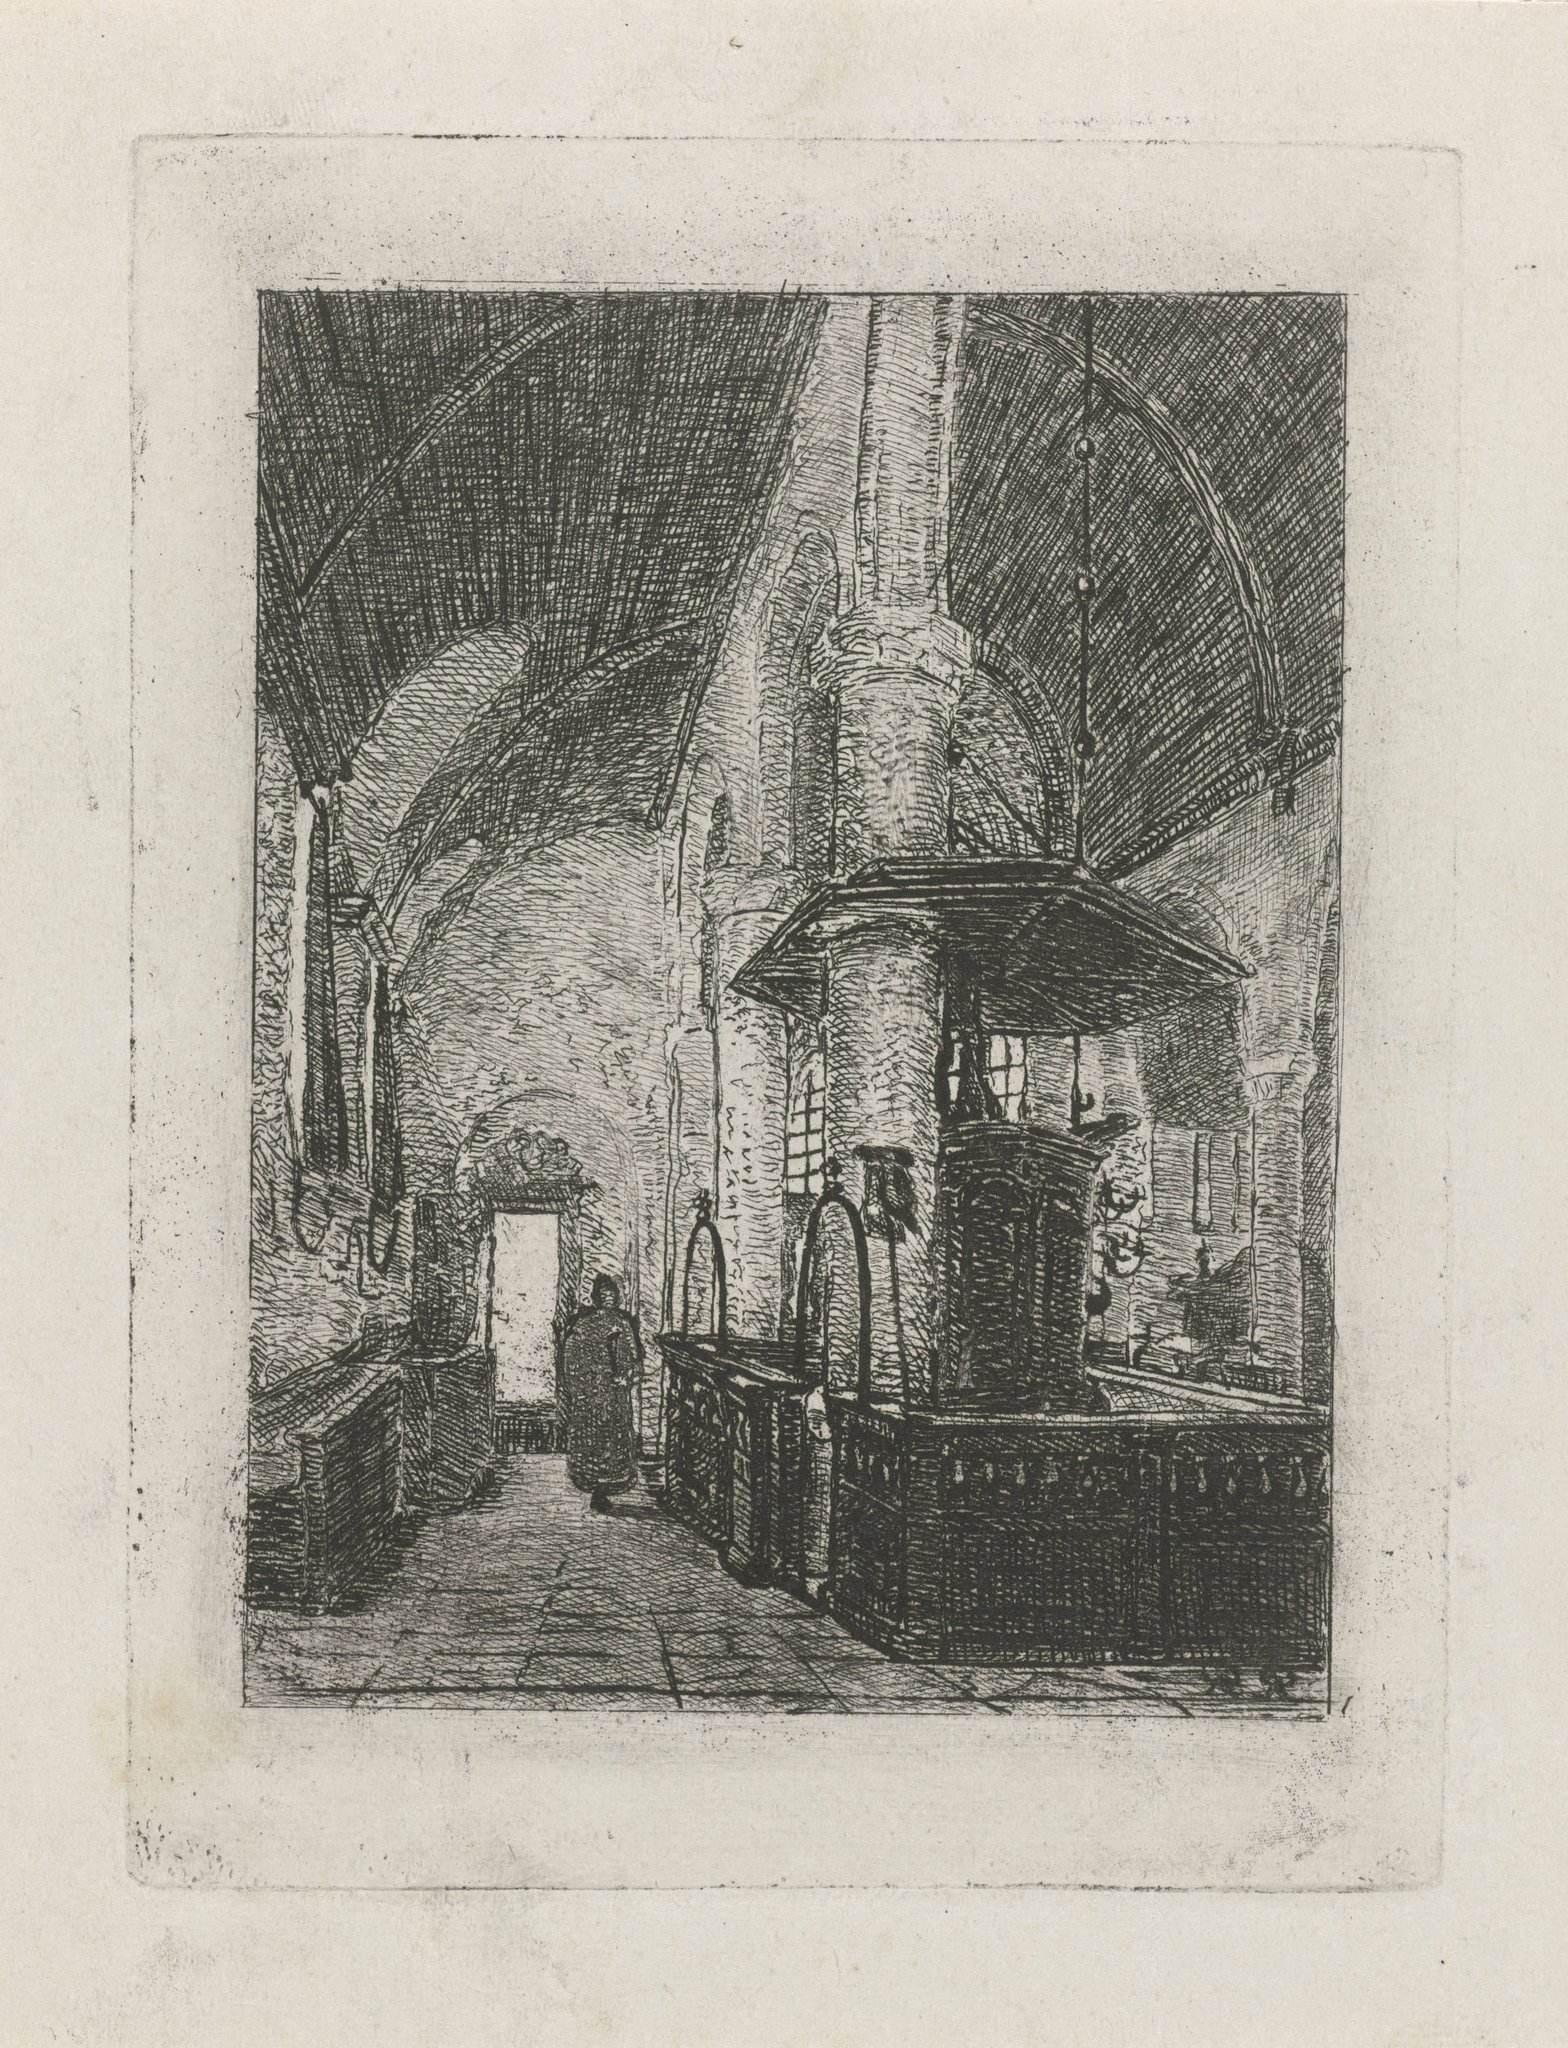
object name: print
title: Kerkinterieur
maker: reinier evert johannes roeterink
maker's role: print maker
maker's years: 1831-1913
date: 1846-1913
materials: paper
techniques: drypoint, etching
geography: netherlands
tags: interior of church, pulpit, ambo, chancel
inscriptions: collector's mark: Lugt 2228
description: Gezicht op het interieur van een kerk met rechts de preekstoel en links een figuur.